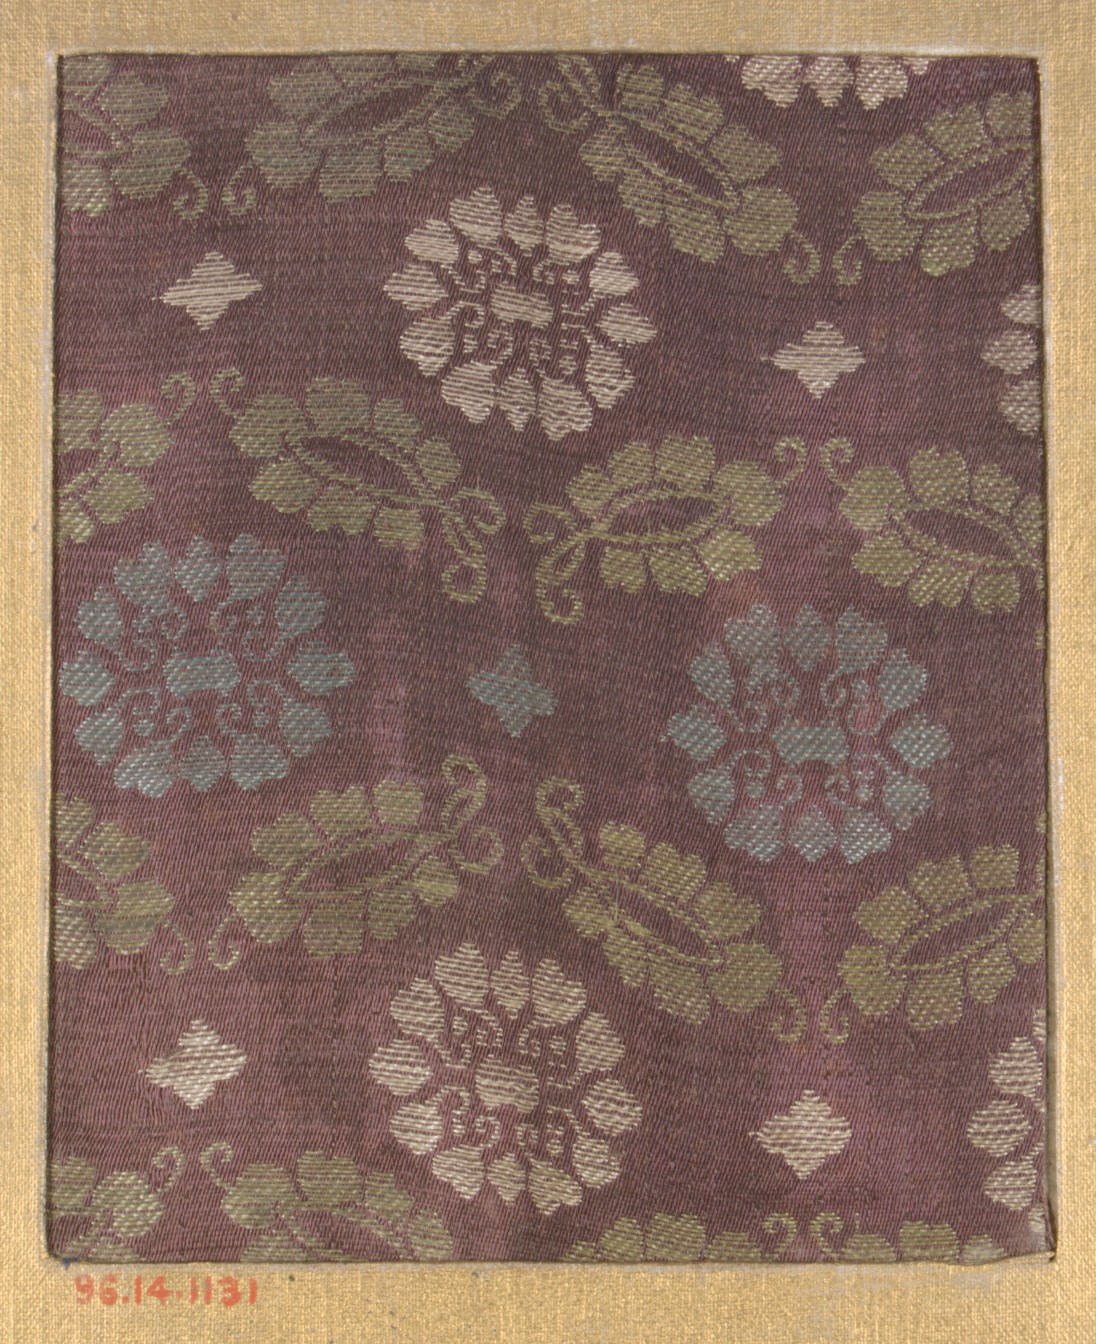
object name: piece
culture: japanese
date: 1701-1900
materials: silk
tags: flowers